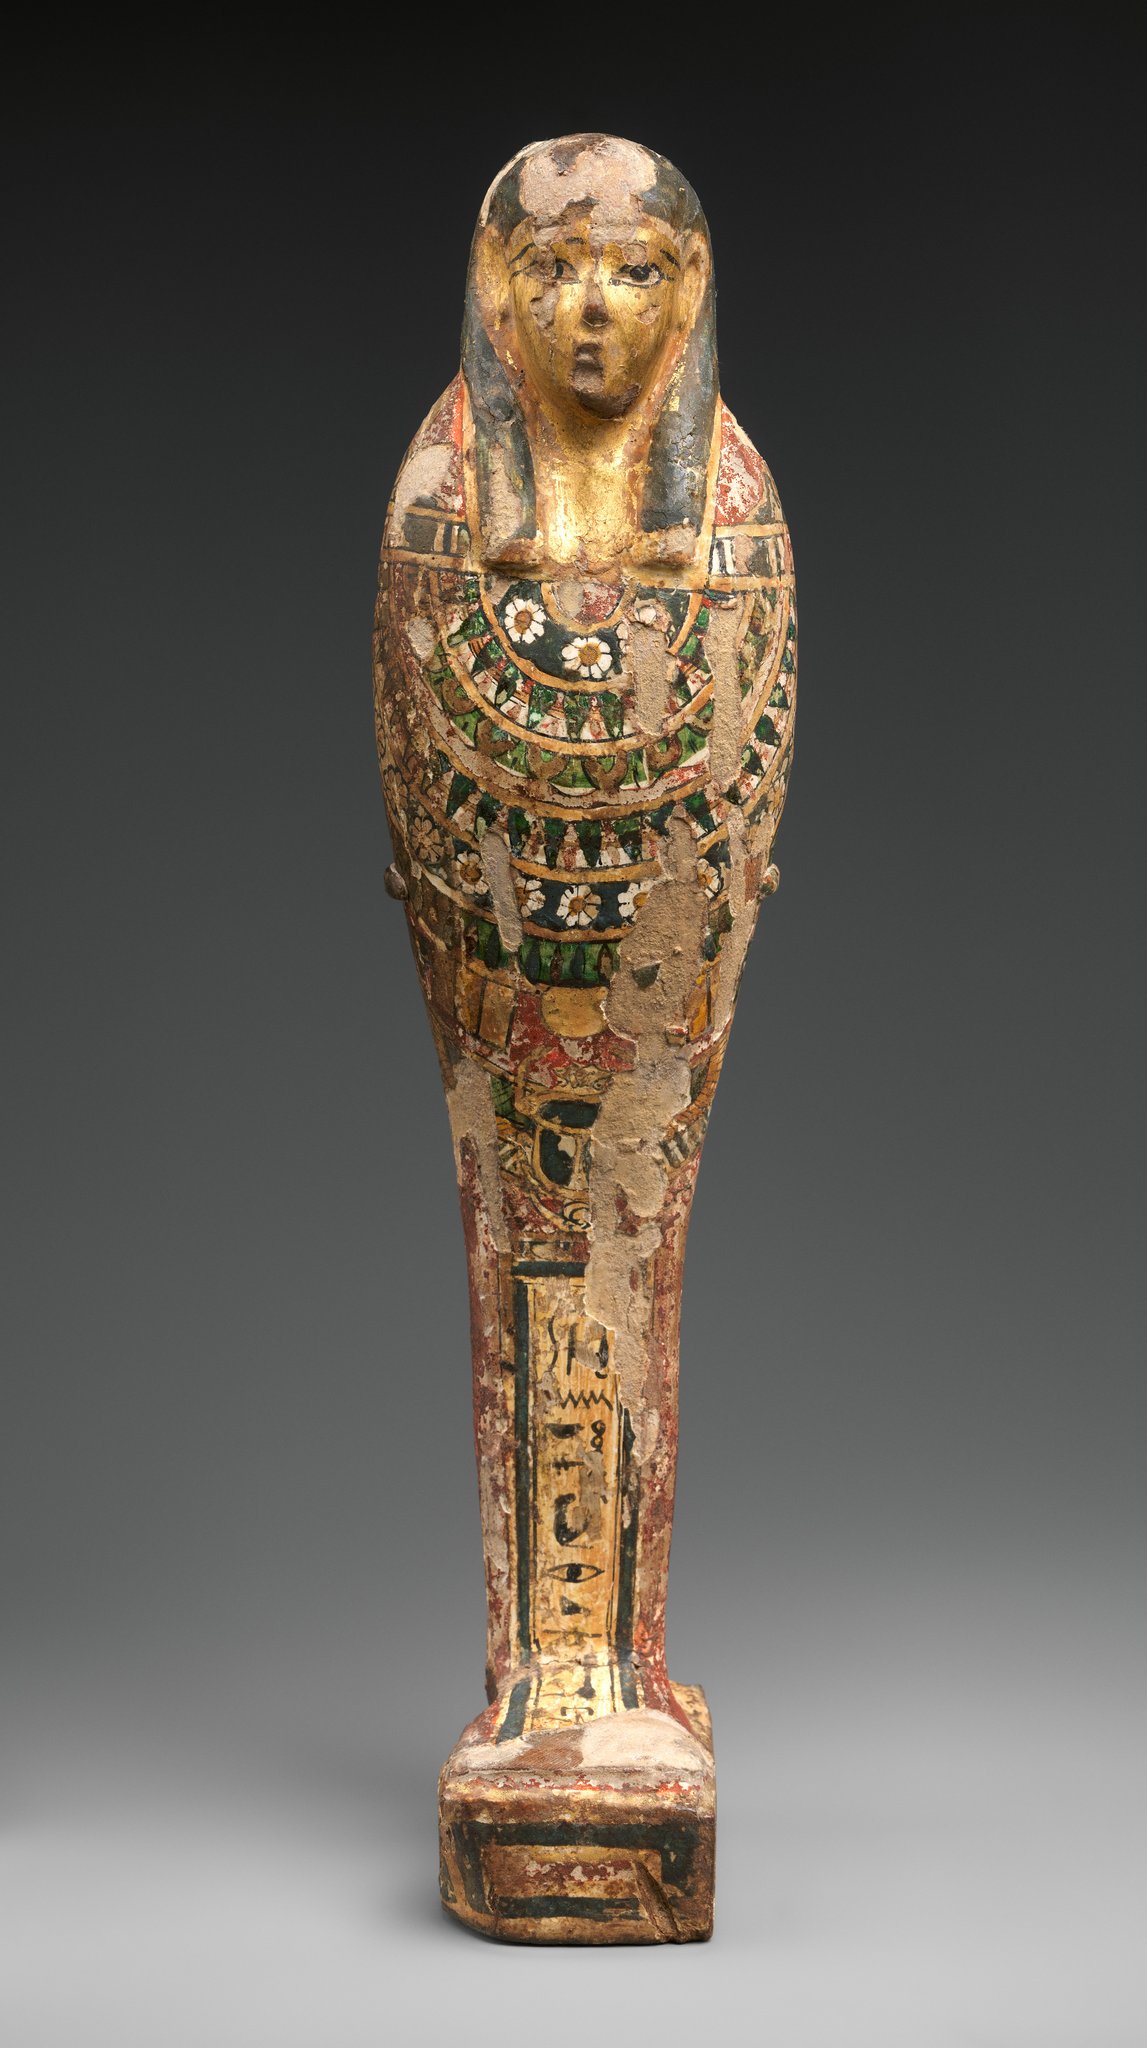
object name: funerary statuette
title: Funerary Statuette naming Teshnefer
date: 332-330 BCE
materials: gesso, paint, wood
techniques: gilding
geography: egypt